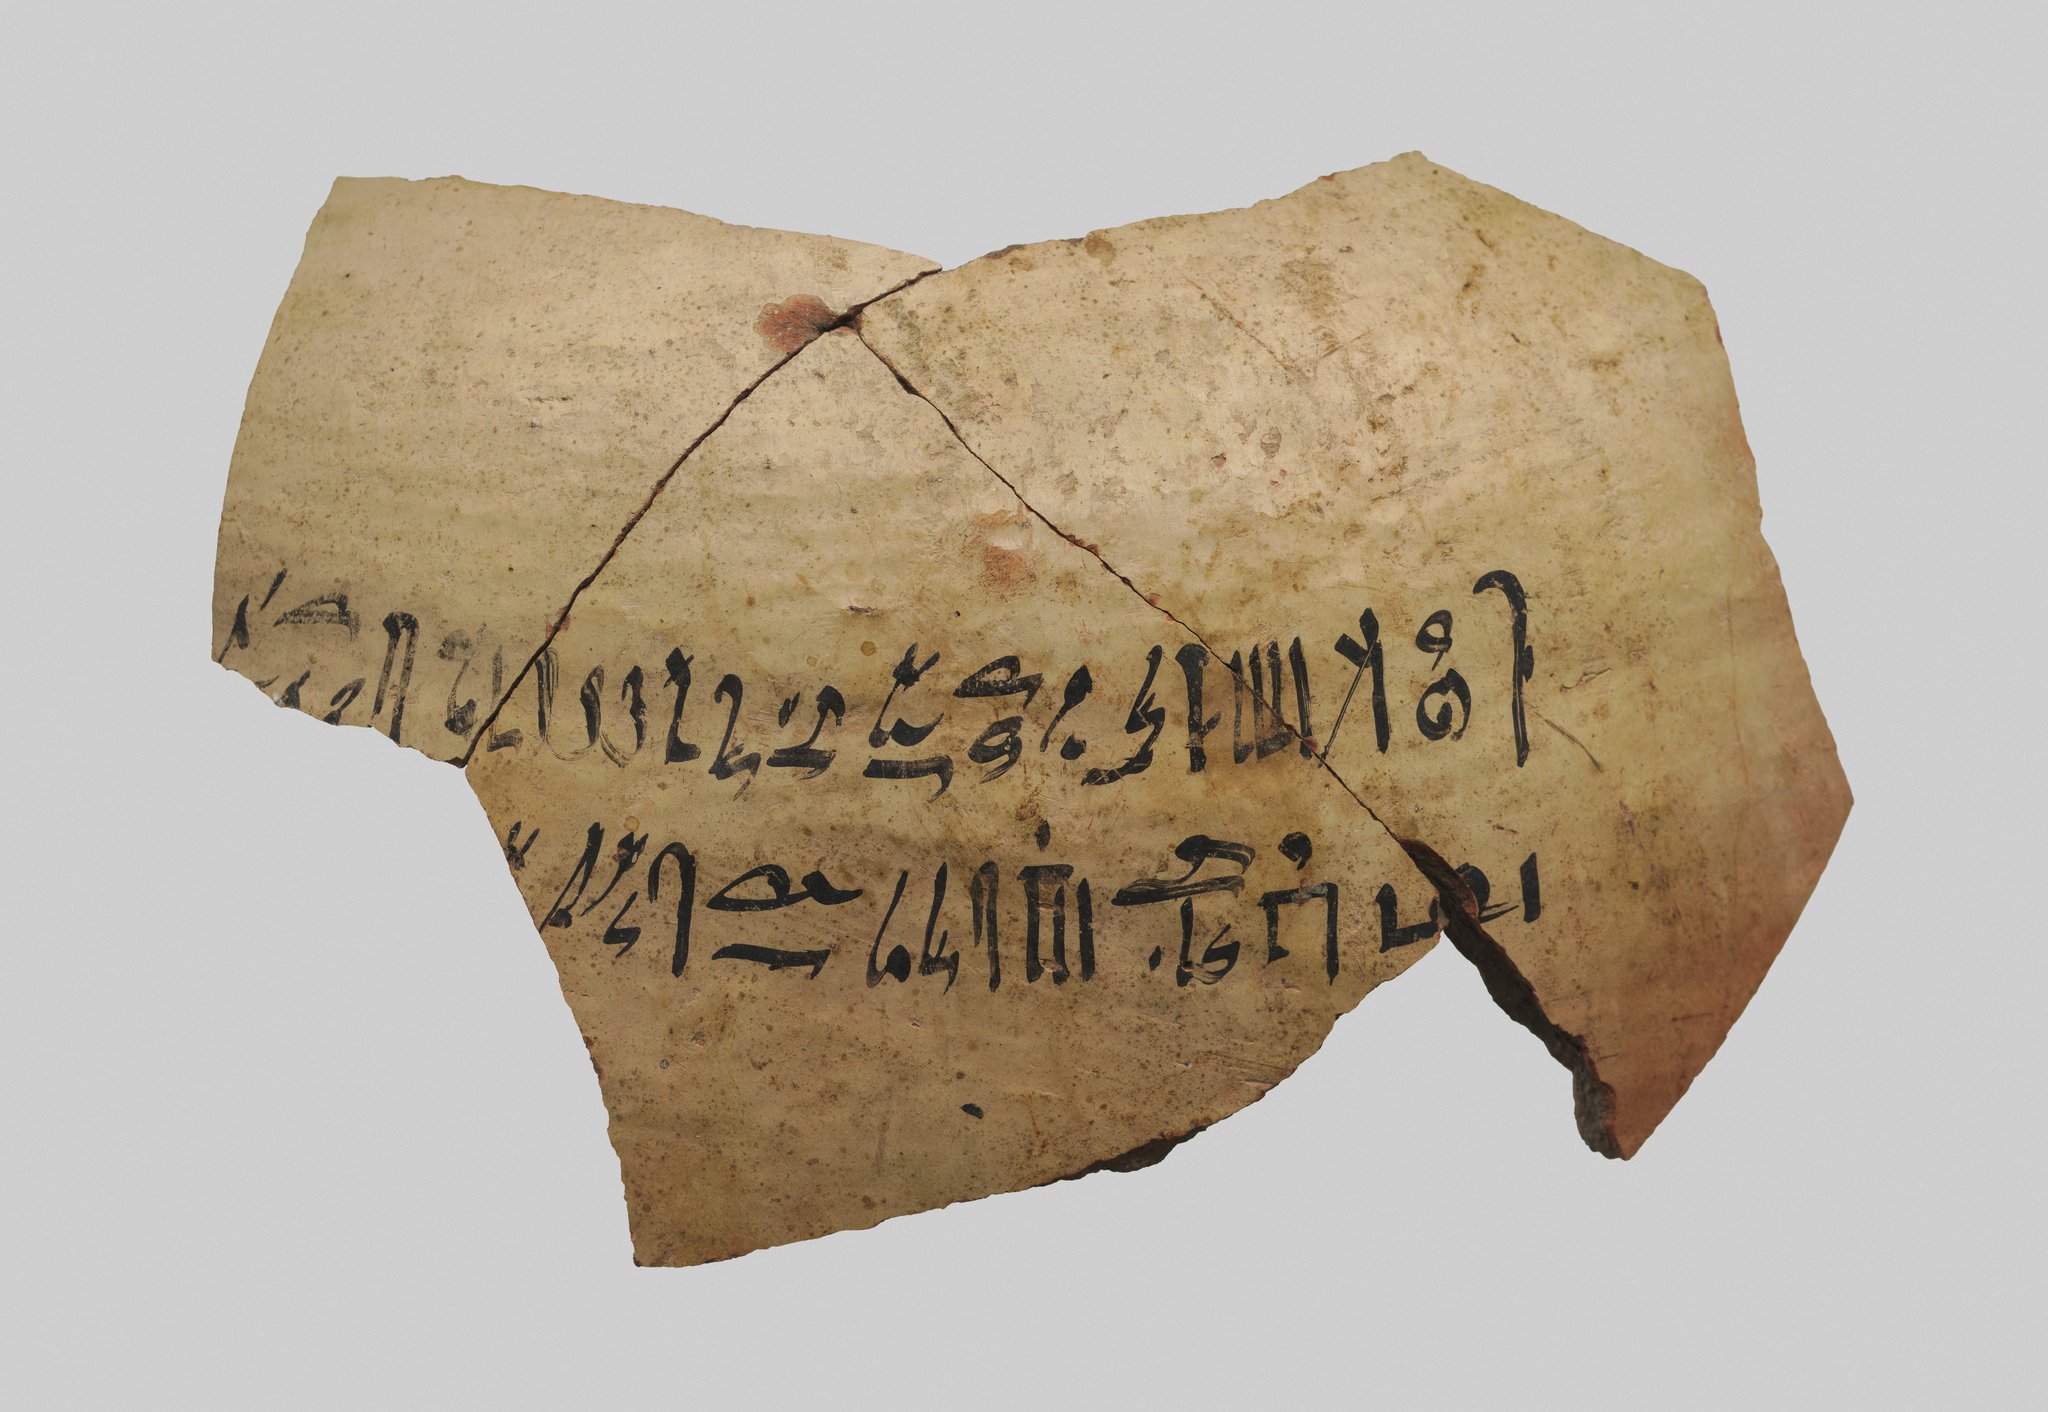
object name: jar label, meat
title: Meat Jar Label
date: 1390-1352 BCE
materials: pigment, pottery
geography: egypt